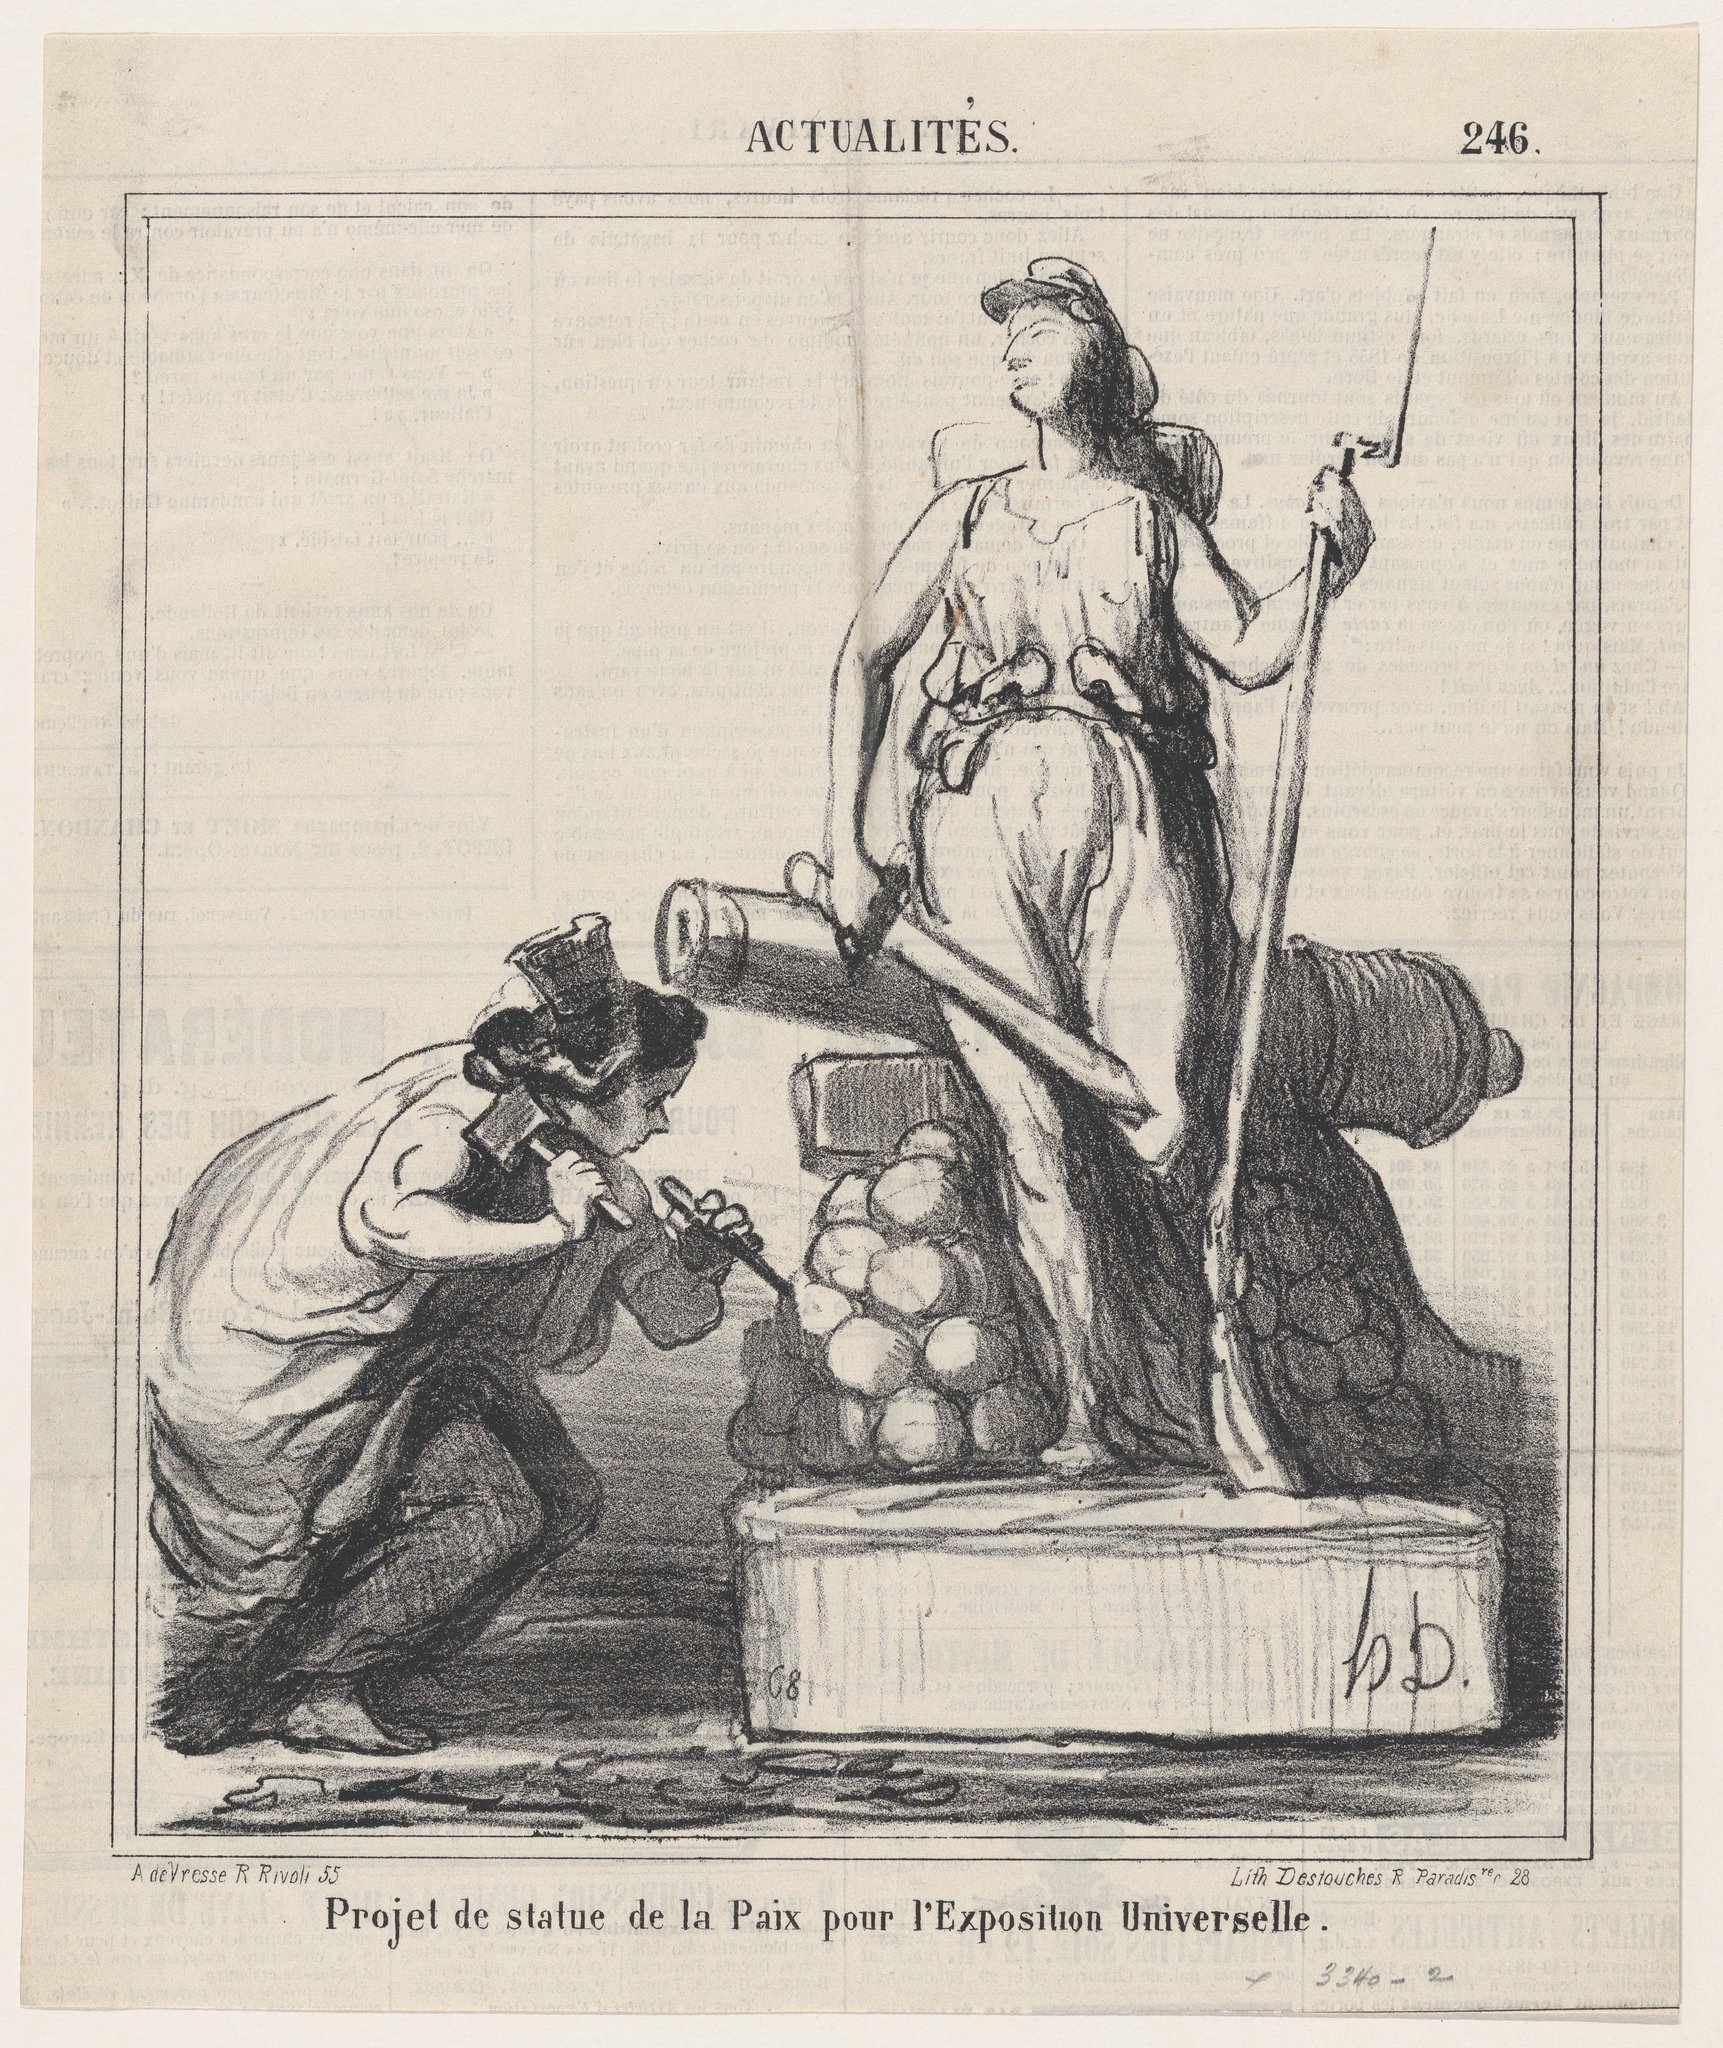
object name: print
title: Project for the statue of peace at the Universal Exposition, from 'News of the day,' published in "Le Charivari"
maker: honoré daumier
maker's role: artist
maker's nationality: french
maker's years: 1808-1879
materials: paper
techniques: lithograph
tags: cannons,women,working